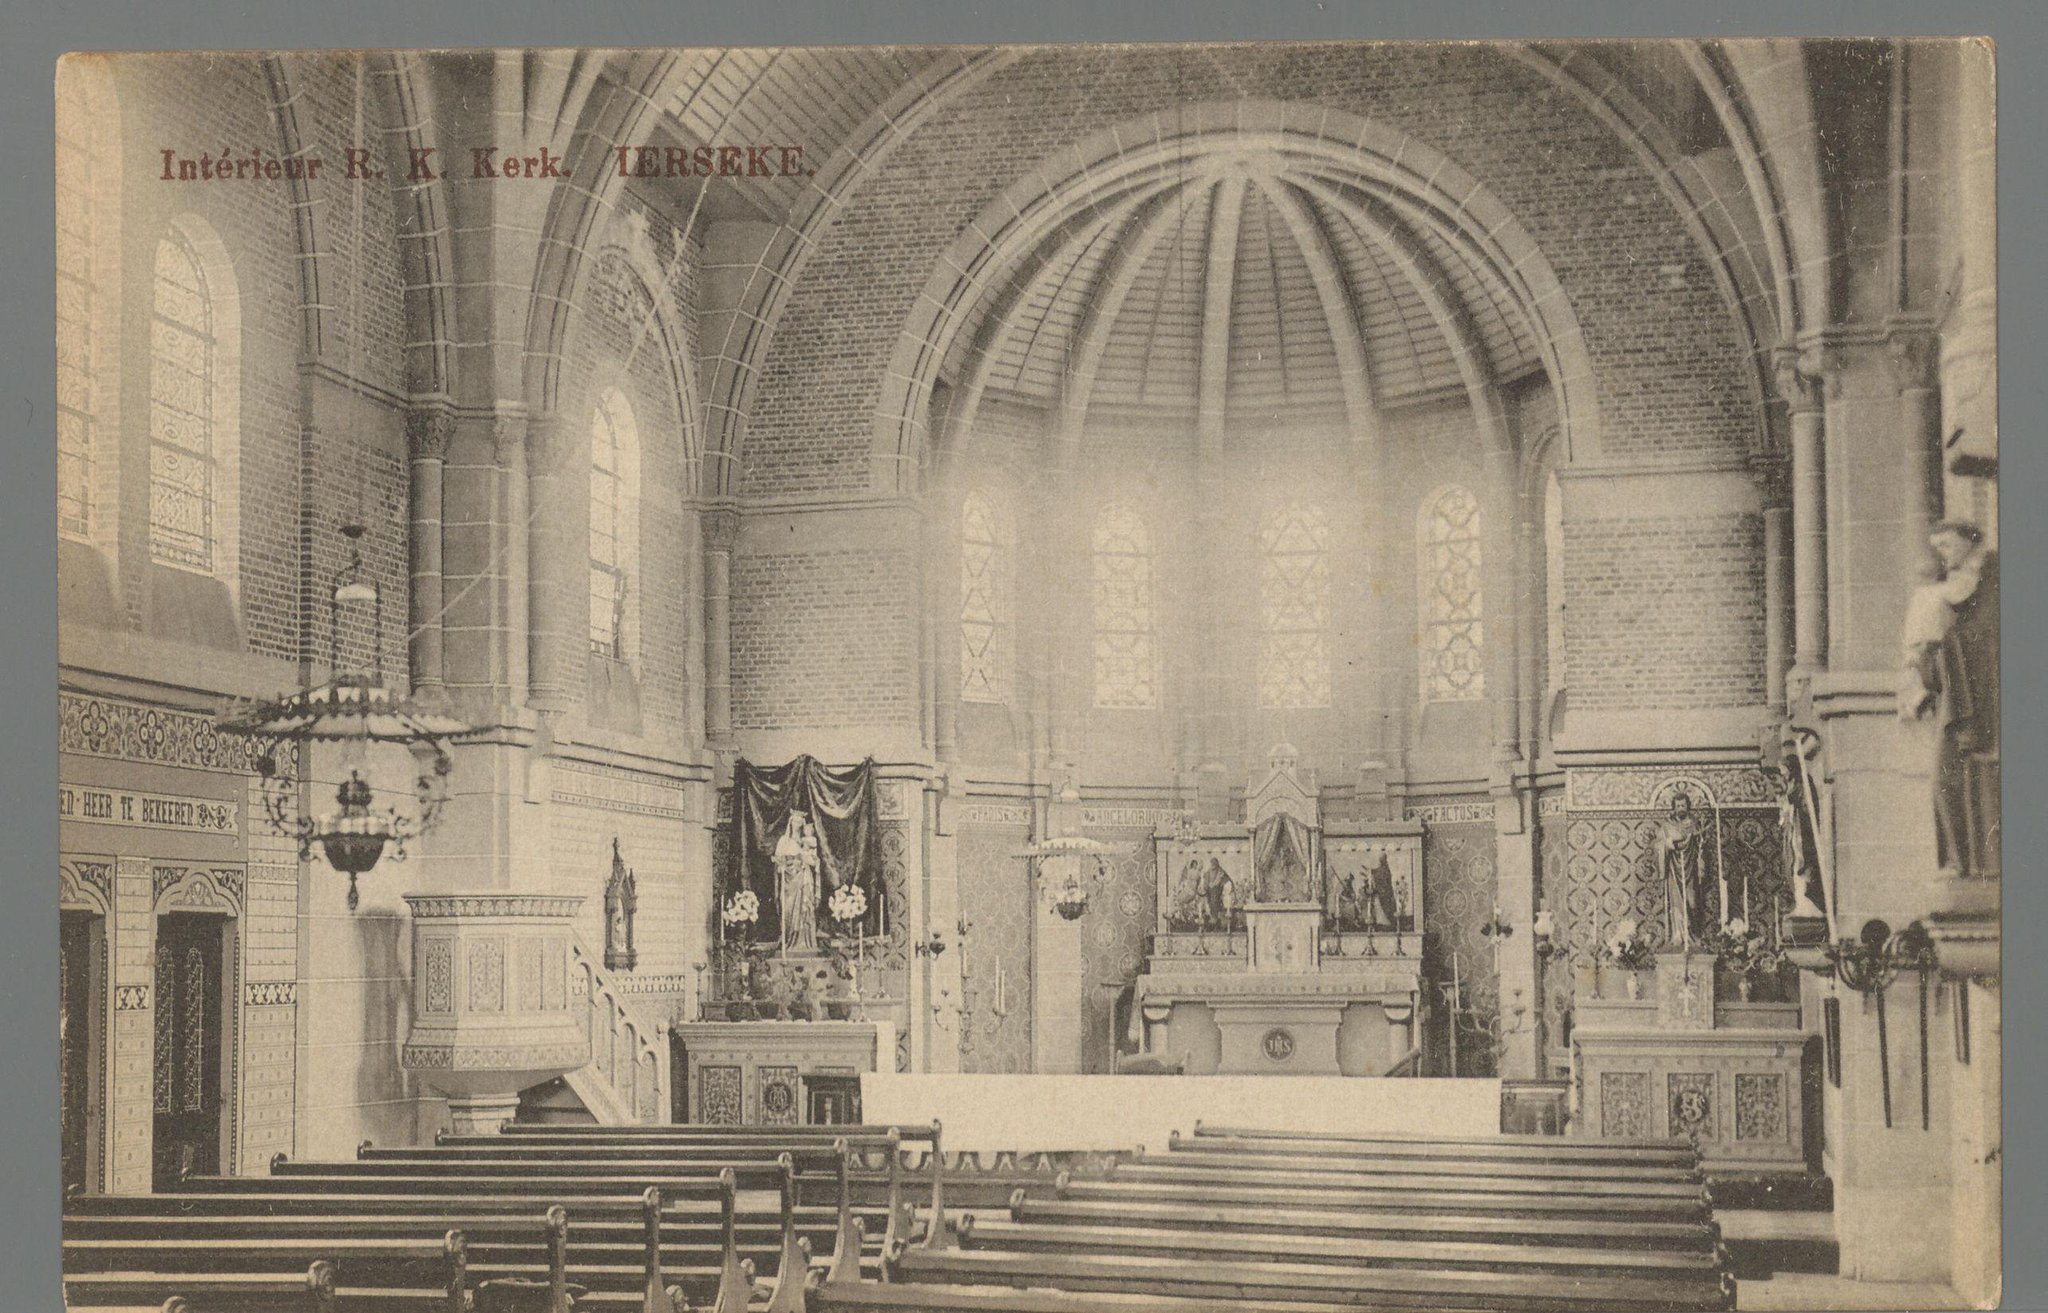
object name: photomechanical print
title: Intérieur R. K. Kerk. Ierseke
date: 1905-1911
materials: cardboard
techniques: photograph, writing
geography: yerseke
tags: interior of church, altar with altar-piece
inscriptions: postage stamp